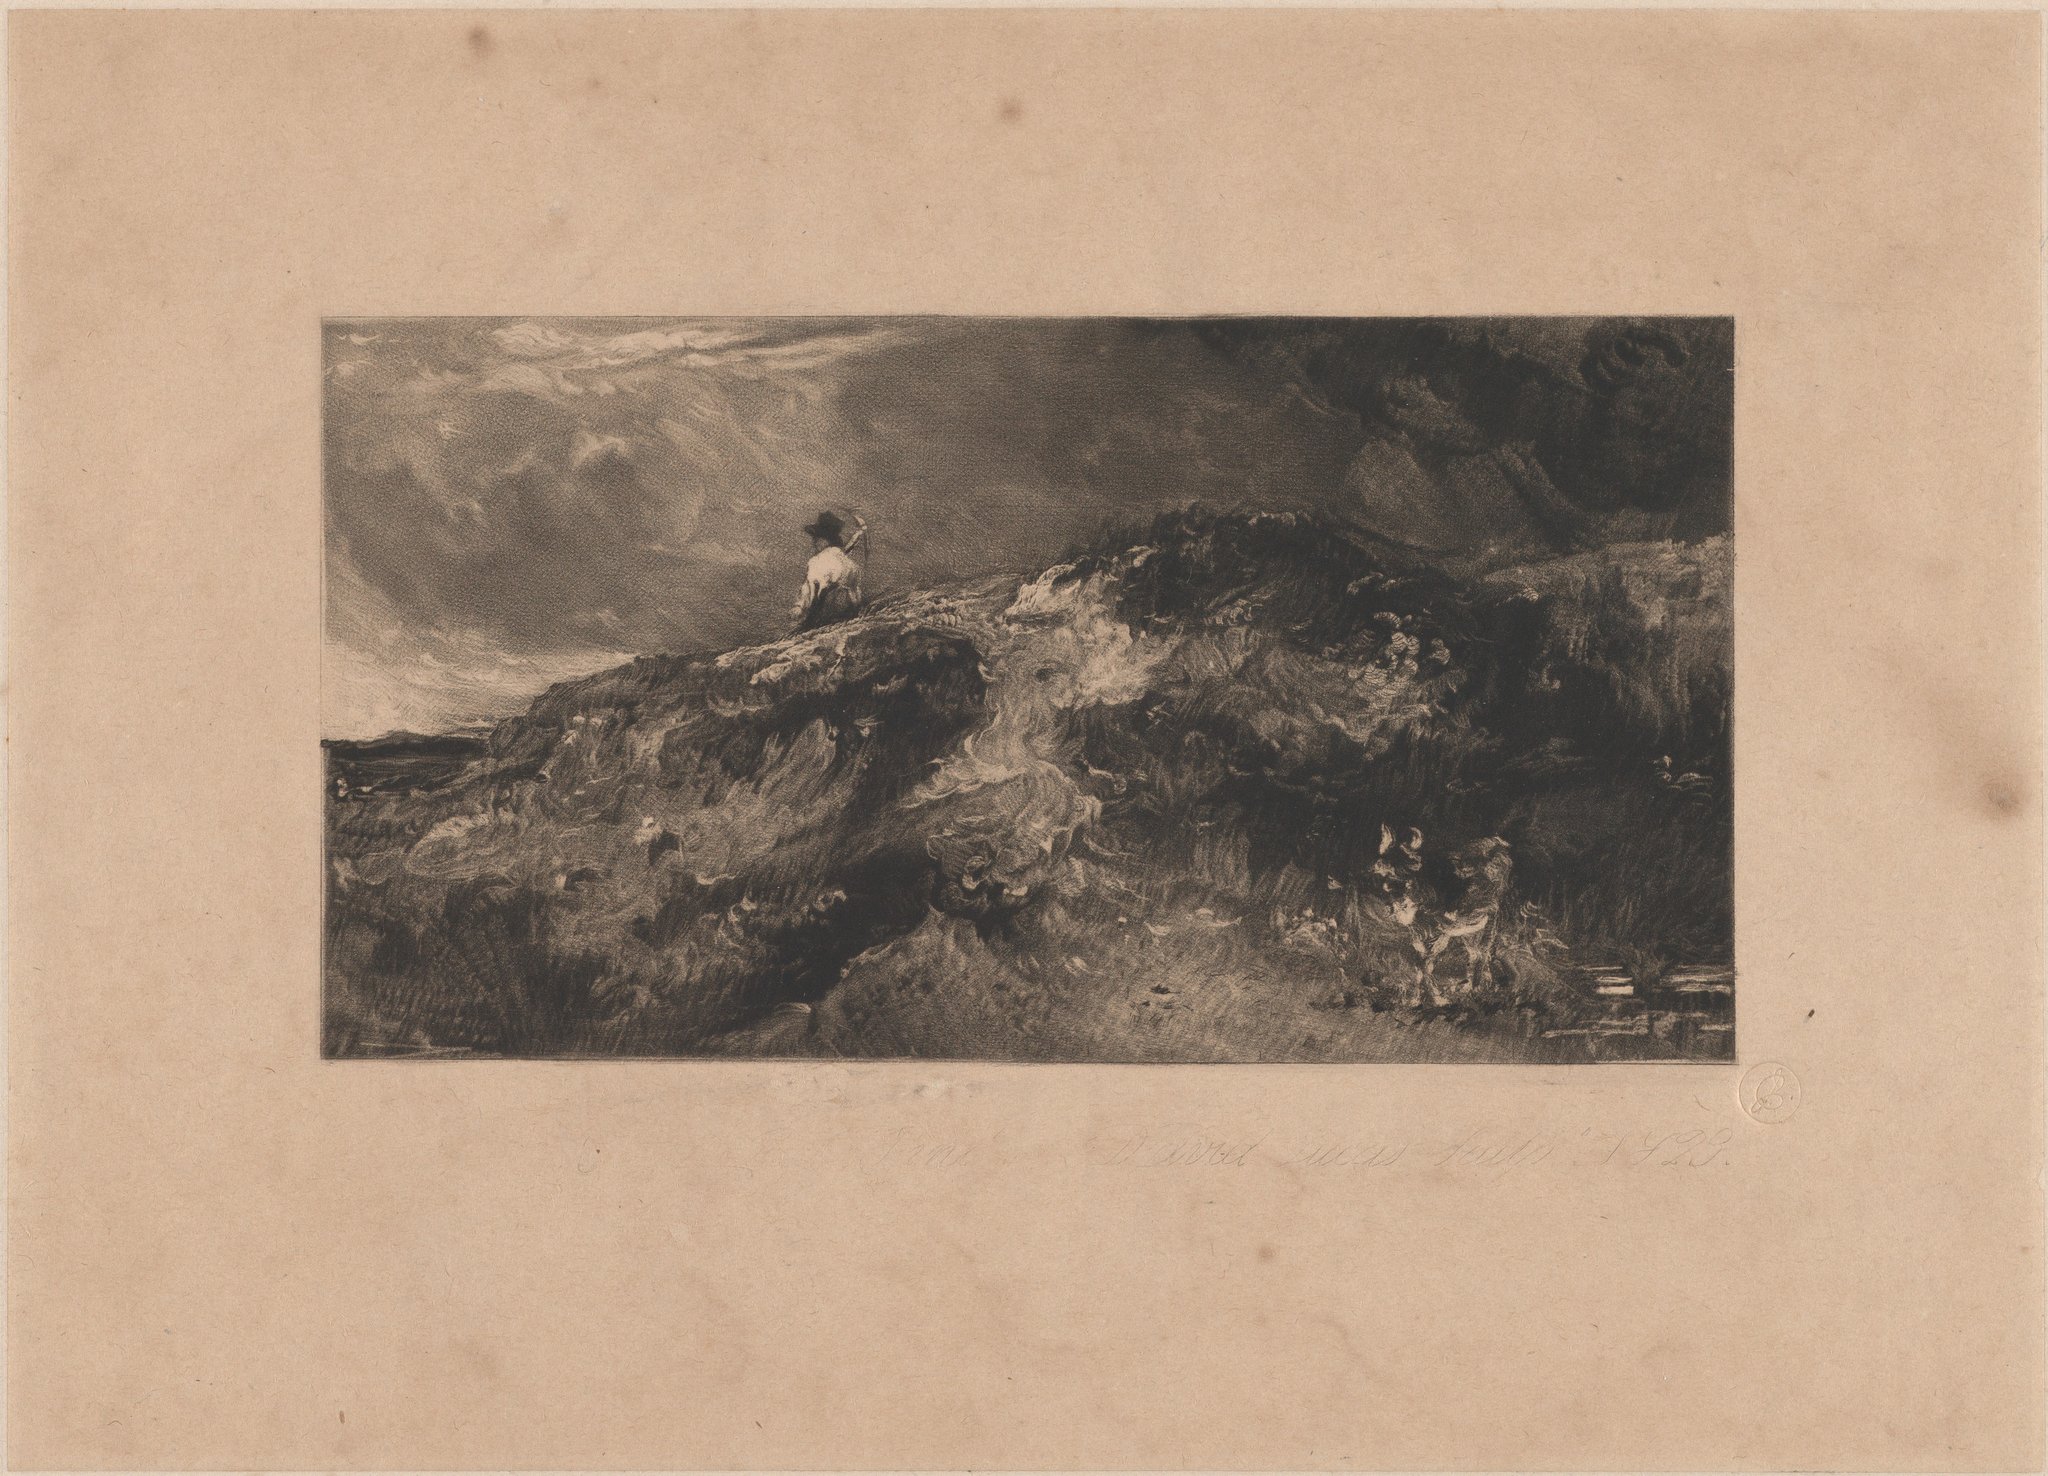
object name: print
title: Hampstead Heath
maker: david lucas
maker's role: artist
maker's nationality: british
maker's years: 1802-1881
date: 1829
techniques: mezzotint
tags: men,landscapes,storms